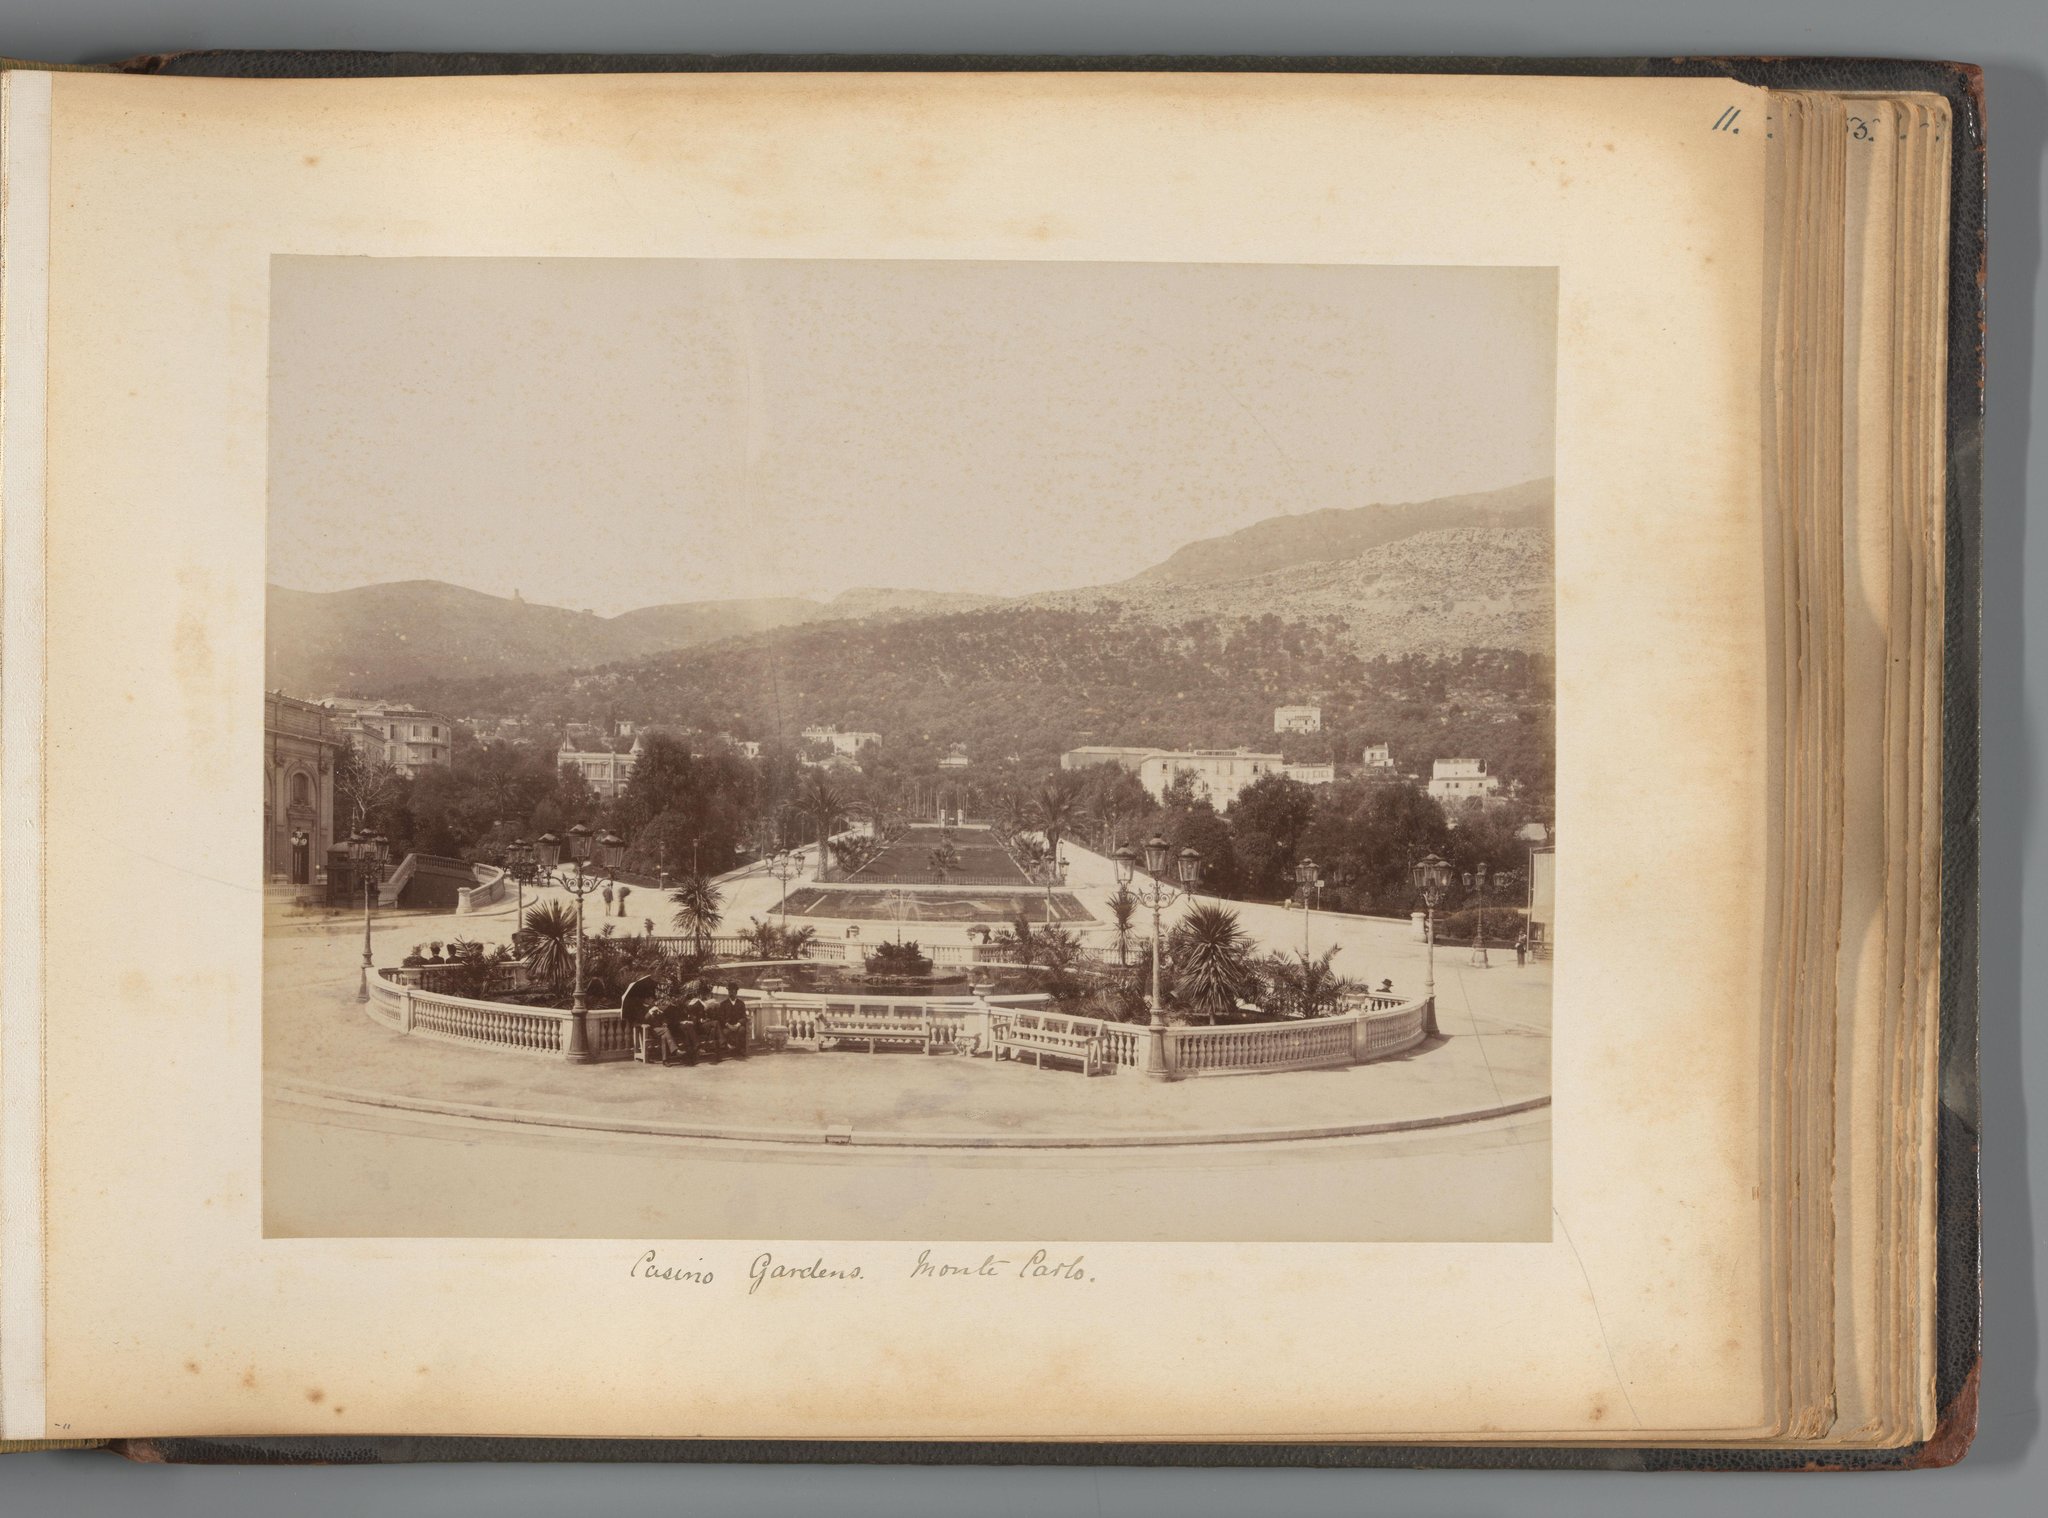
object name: photograph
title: Uitzicht vanuit het Monte Carlo Casino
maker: c.c. blackburn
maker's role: fotograaf, luitenant-kolonel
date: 1888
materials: paper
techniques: albumen print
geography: monaco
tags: casino